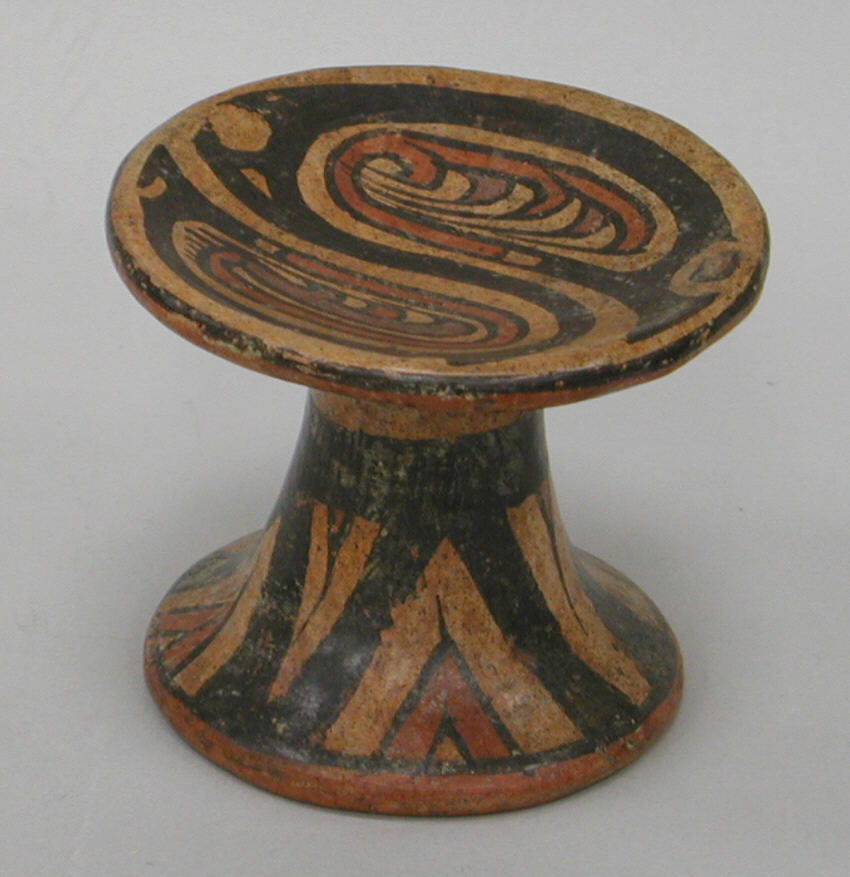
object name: plate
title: Painted Ceramic Pedestal Plate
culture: coclé, macaracas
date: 701-1200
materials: ceramic, pigment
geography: panama